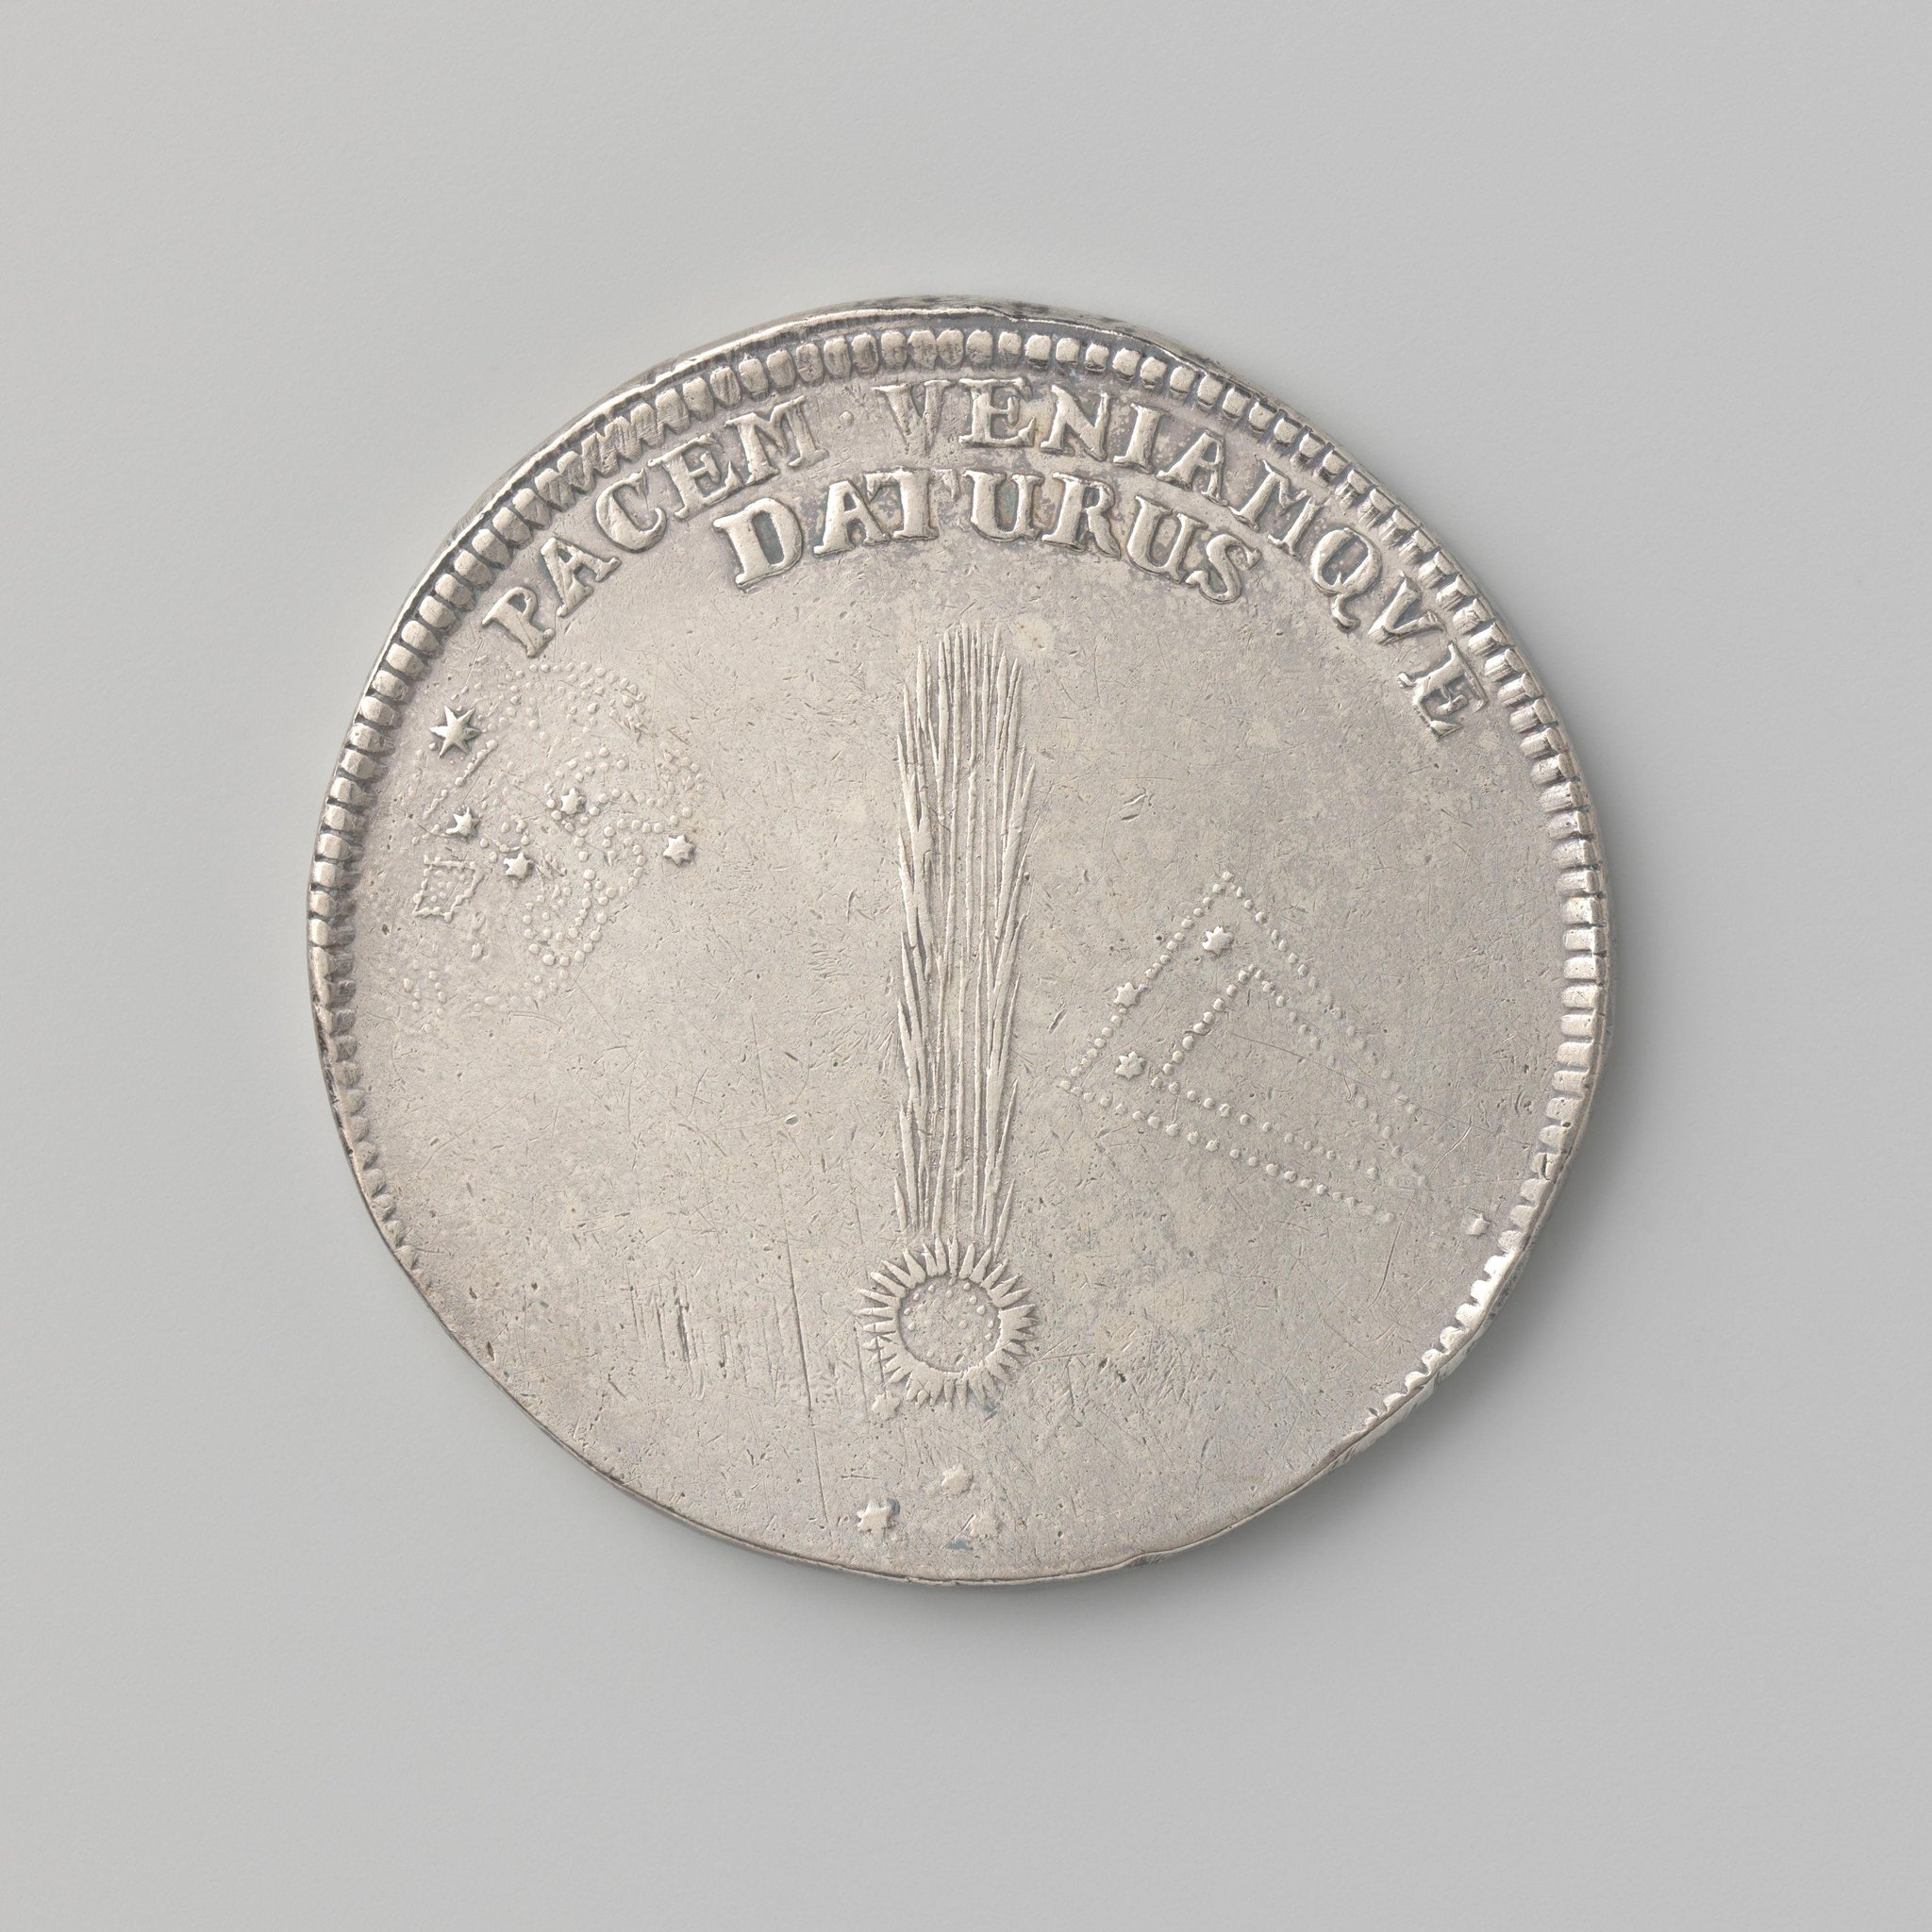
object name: history medal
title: Verschijning van een komeet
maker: Anonymous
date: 1677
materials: silver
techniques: striking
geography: netherlands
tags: netherlands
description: Zilveren penning. Voorzijde: komeet tussen Andromeda en een sterrenstelsel in de vorm van een driehoek onder opschrift. Keerzijde: gekroonde (Nederlandse) leeuw verschuilt zich achter bundel samengebonden wapens voor de brandende (Franse) zon binnen omschrift